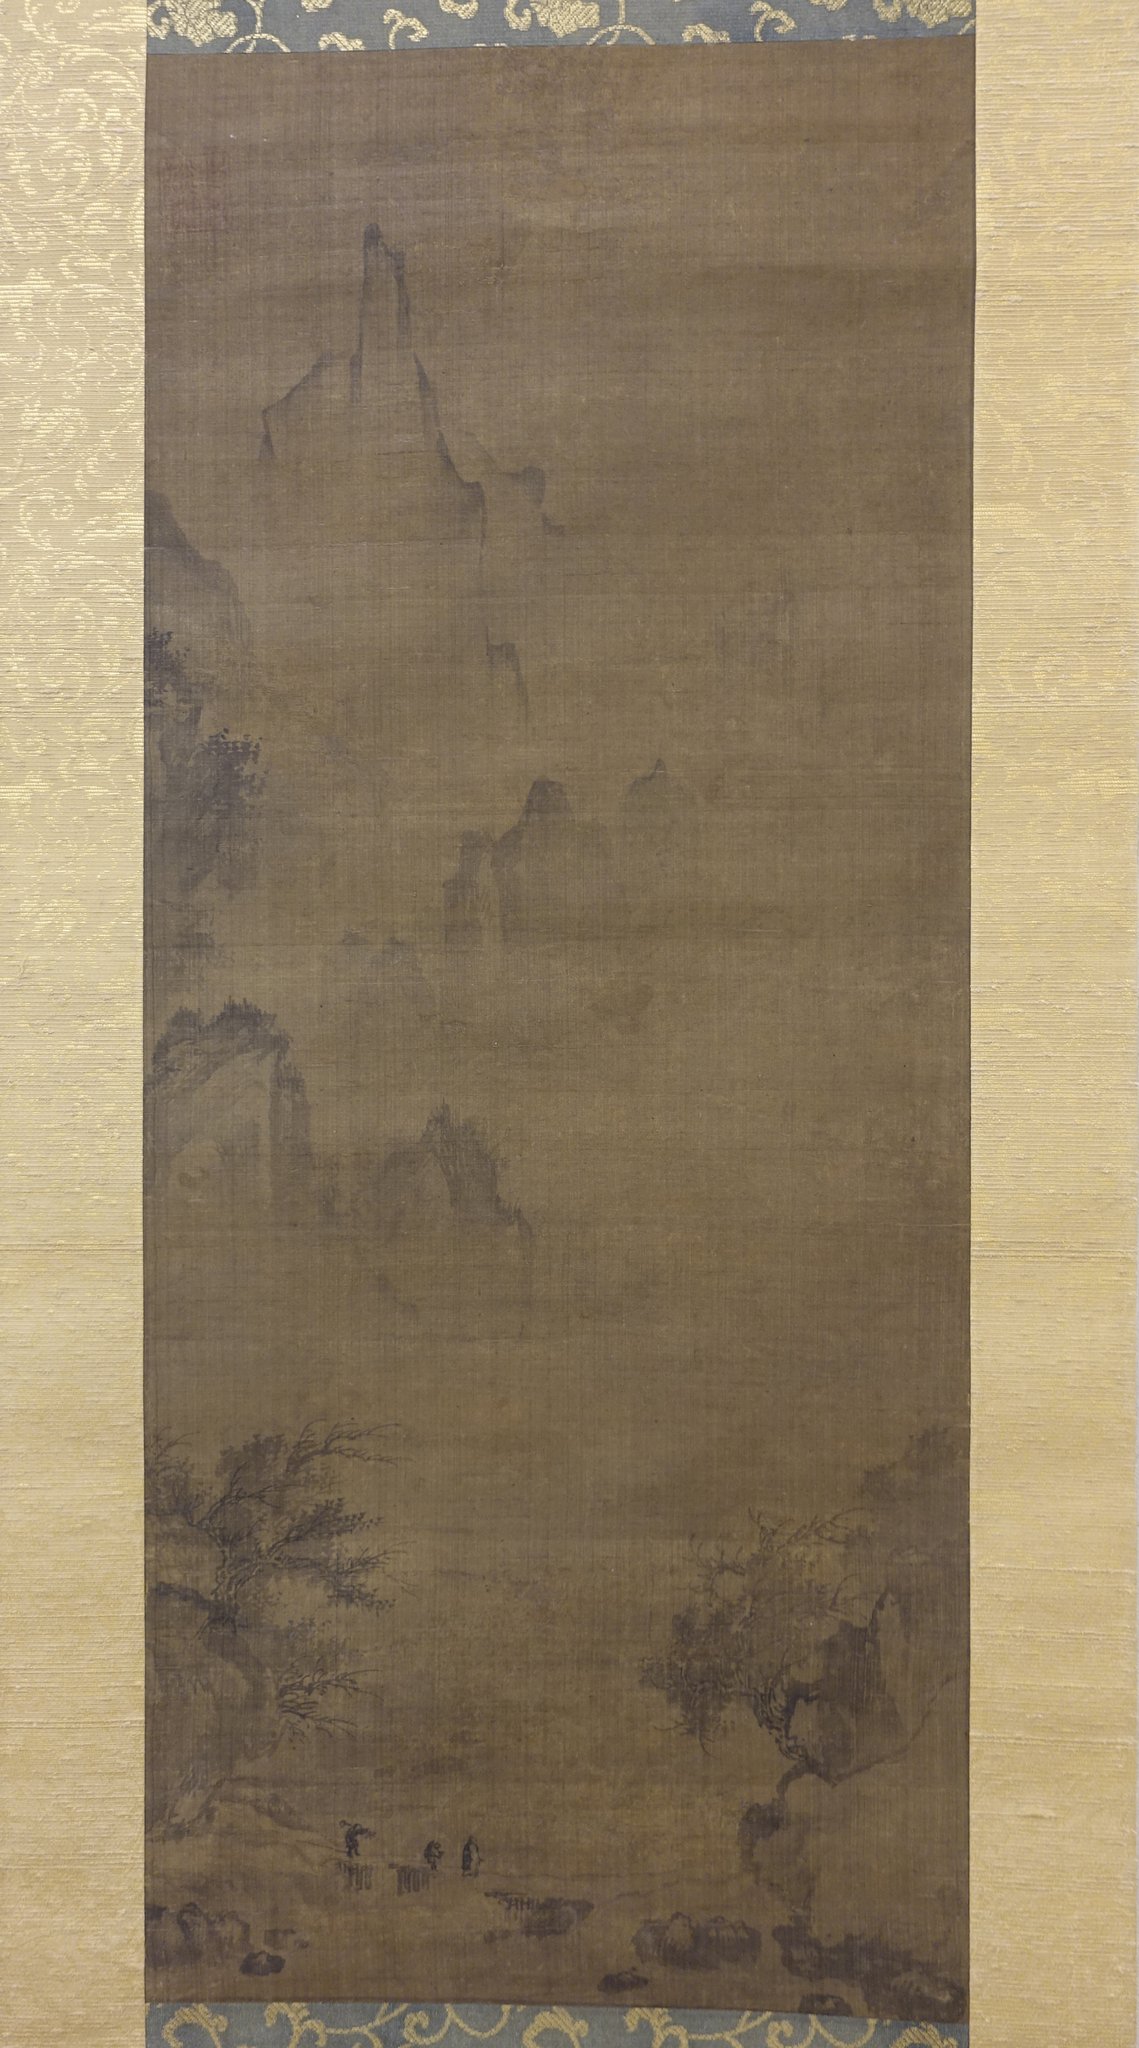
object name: hanging scroll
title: Rainy Landscape with Travelers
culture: korean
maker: unidentified artist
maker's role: artist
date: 1401-1500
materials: ink, silk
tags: mountains,landscapes